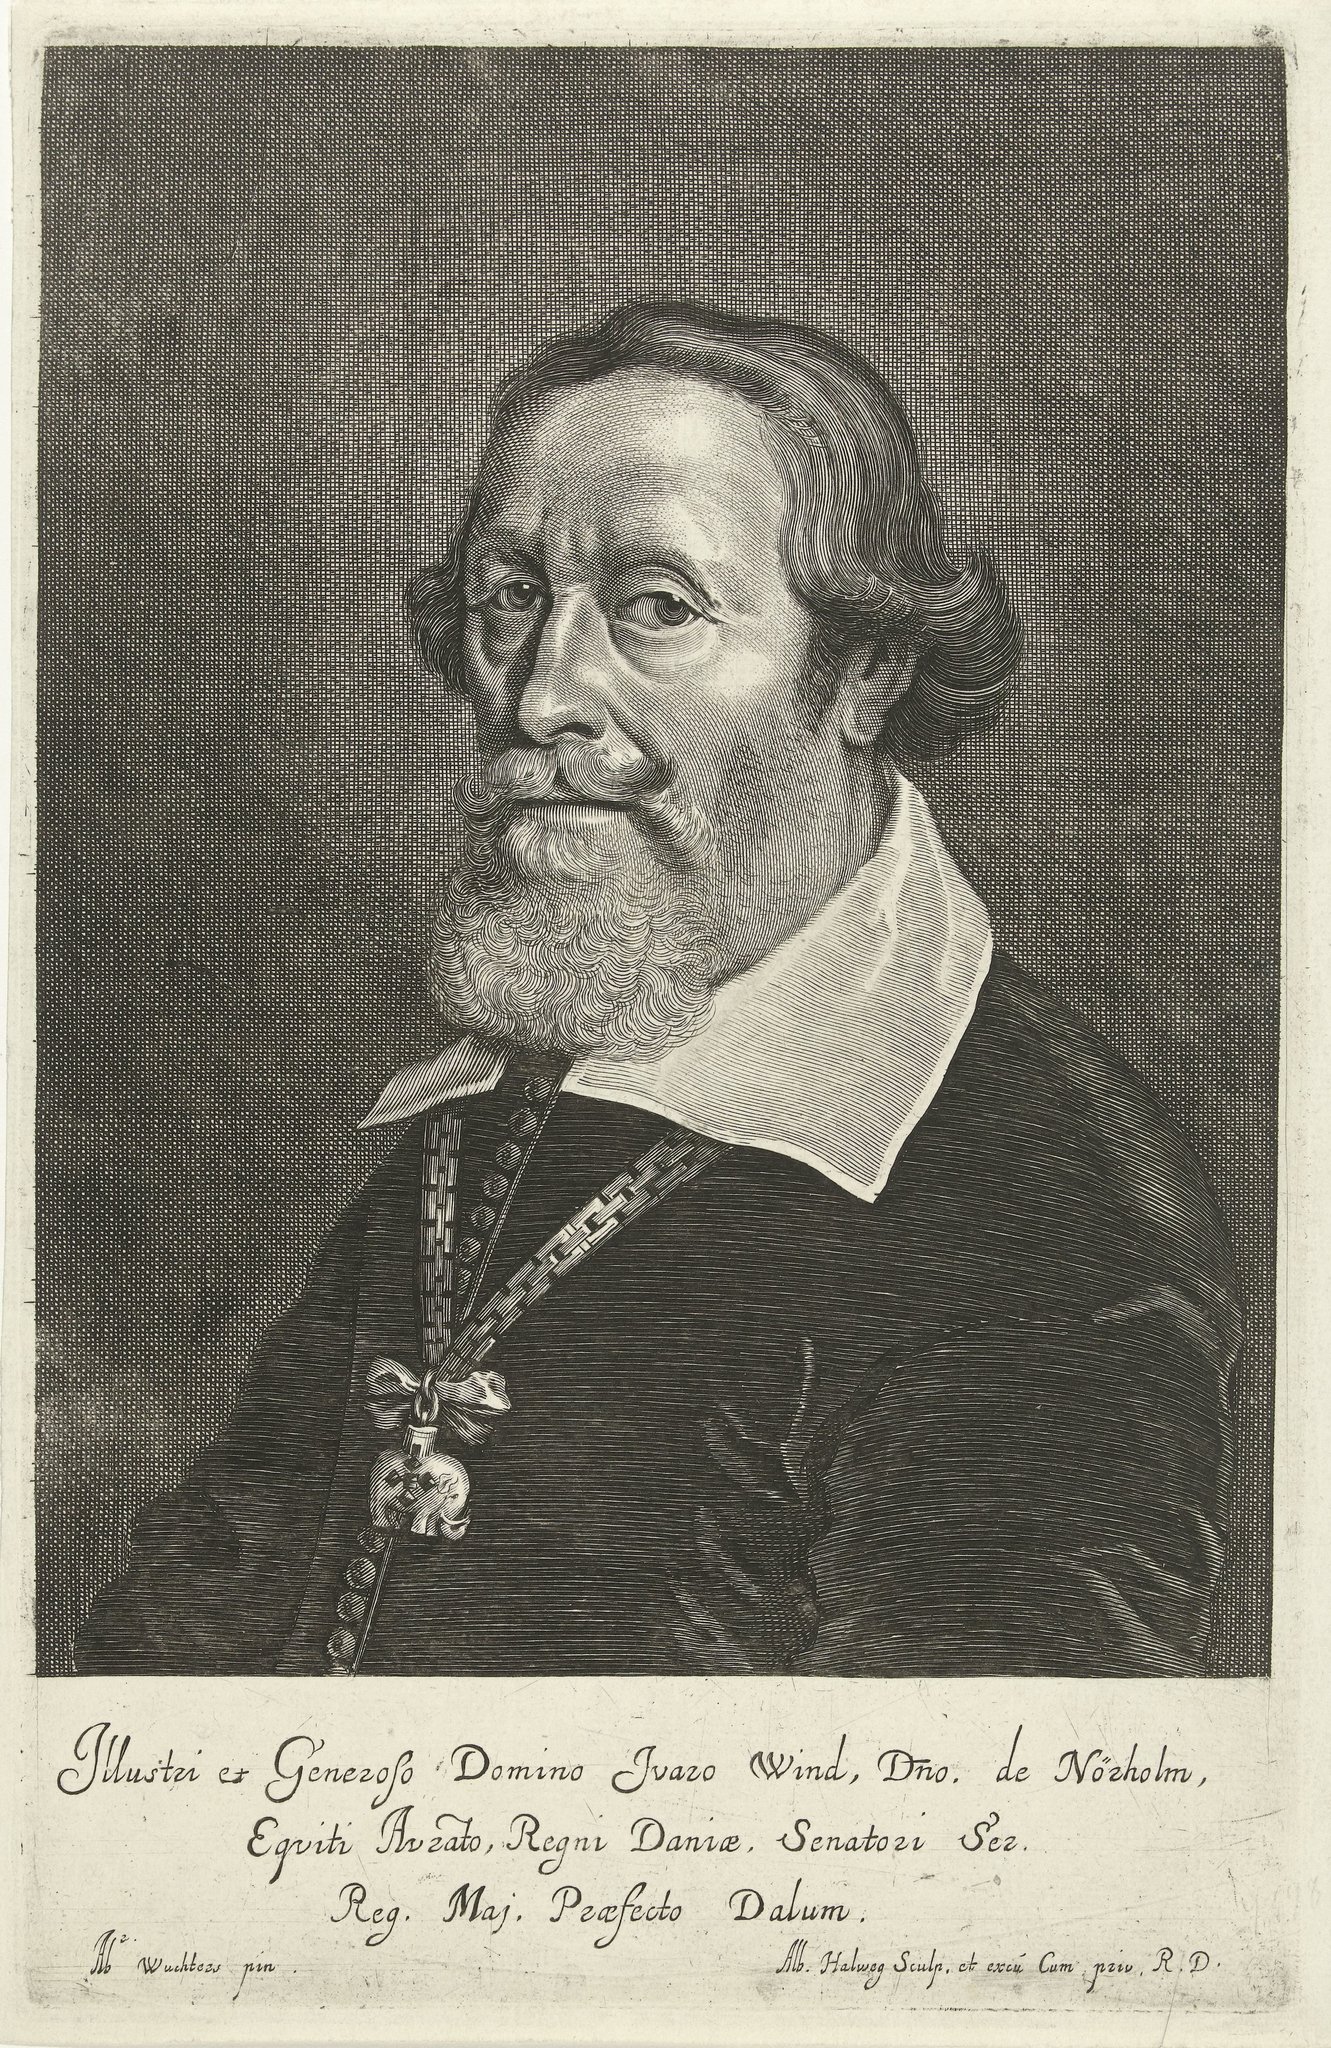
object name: print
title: Portret van Ivar Wind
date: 1655-1659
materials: paper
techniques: engraving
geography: copenhagen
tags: beard, necklace (+ men's clothes)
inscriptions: collector's mark: Lugt 2760, collector's mark: Lugt 2228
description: Portret naar links van Ivar Wind, met om zijn hals een ketting met een olifant waarop een kruis, symbool voor de Orde van de Olifant. Onder zijn portret een drieregelige tekst in Latijn.